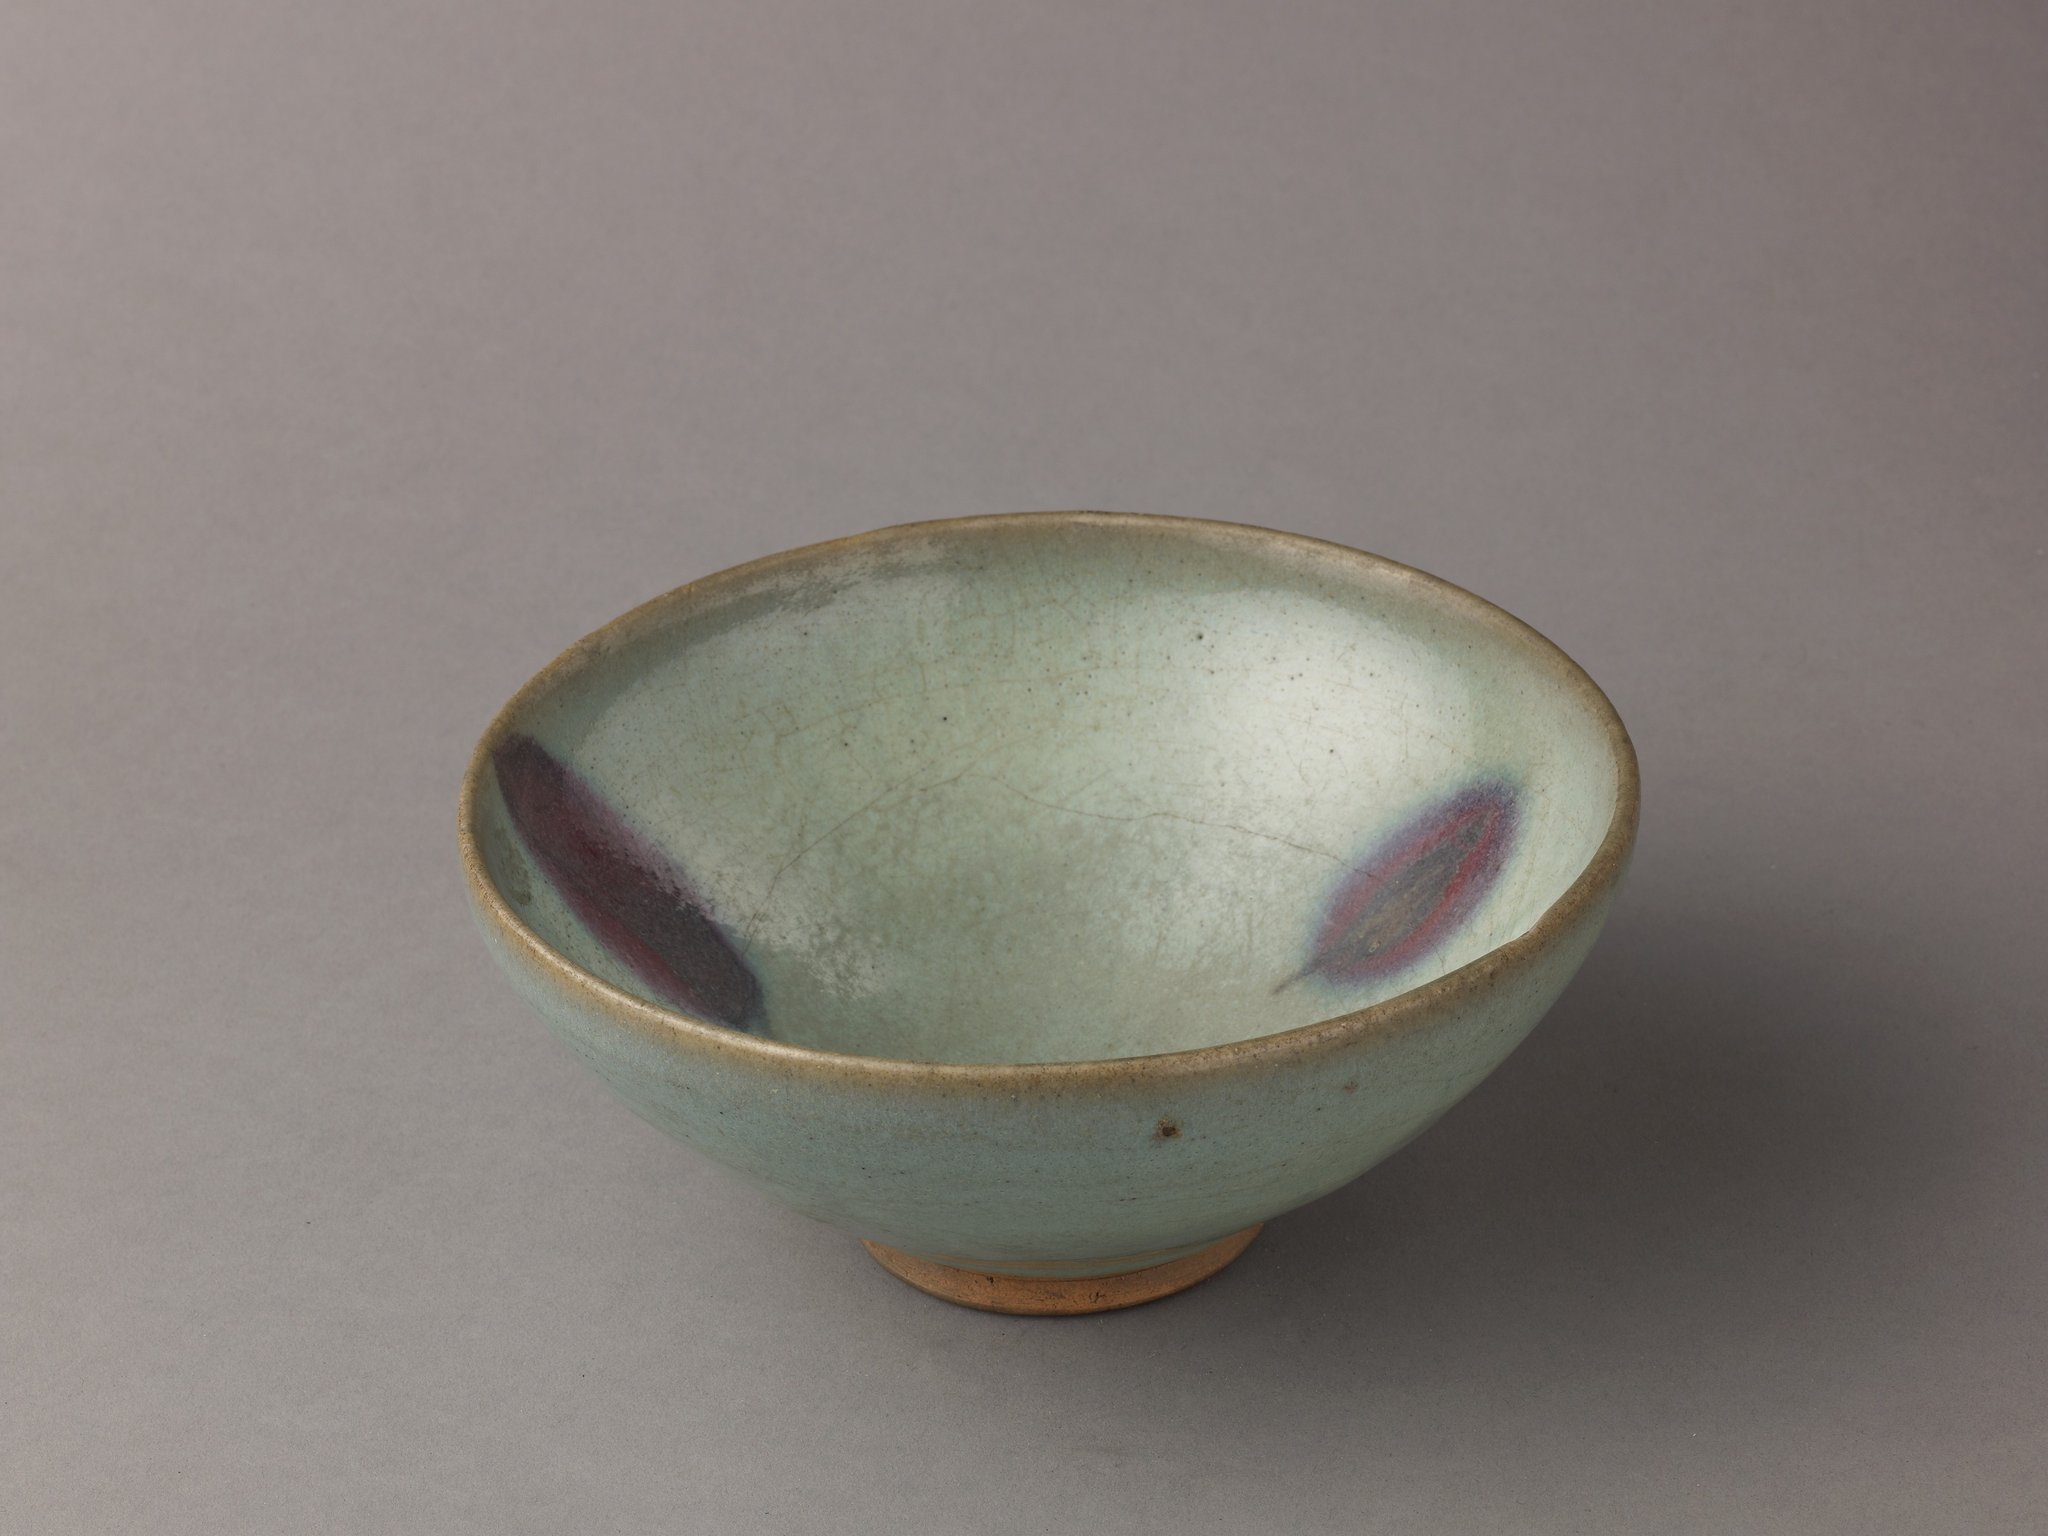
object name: bowl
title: Deep bowl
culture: chinese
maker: chinese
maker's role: artist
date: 1201-1400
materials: glaze, stoneware